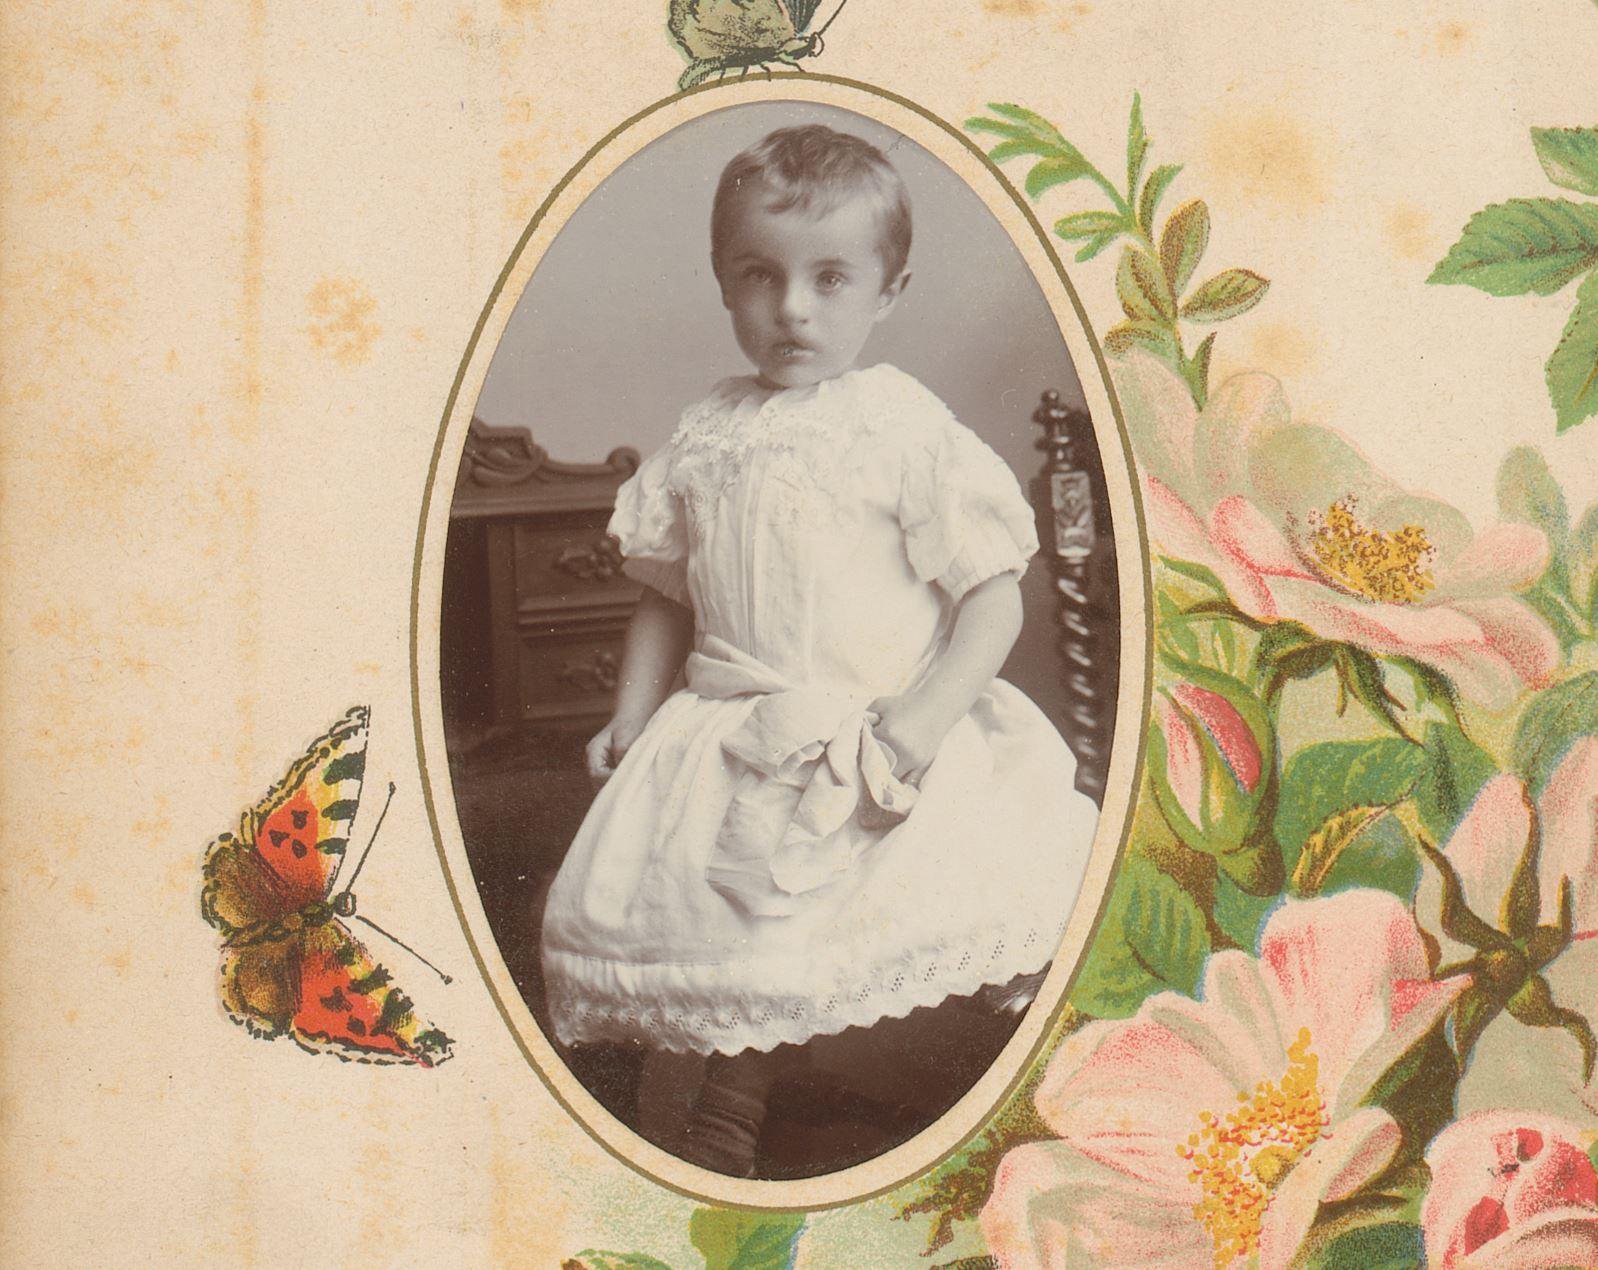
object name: carte de visite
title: Portret van een kind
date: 1860-1900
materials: cardboard, photographic support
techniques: collodion silver print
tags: child, historical persons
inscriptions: inscription: ‘W. J. Wellsted & Son/ (...)/ 20 Paragon St/ Hull’